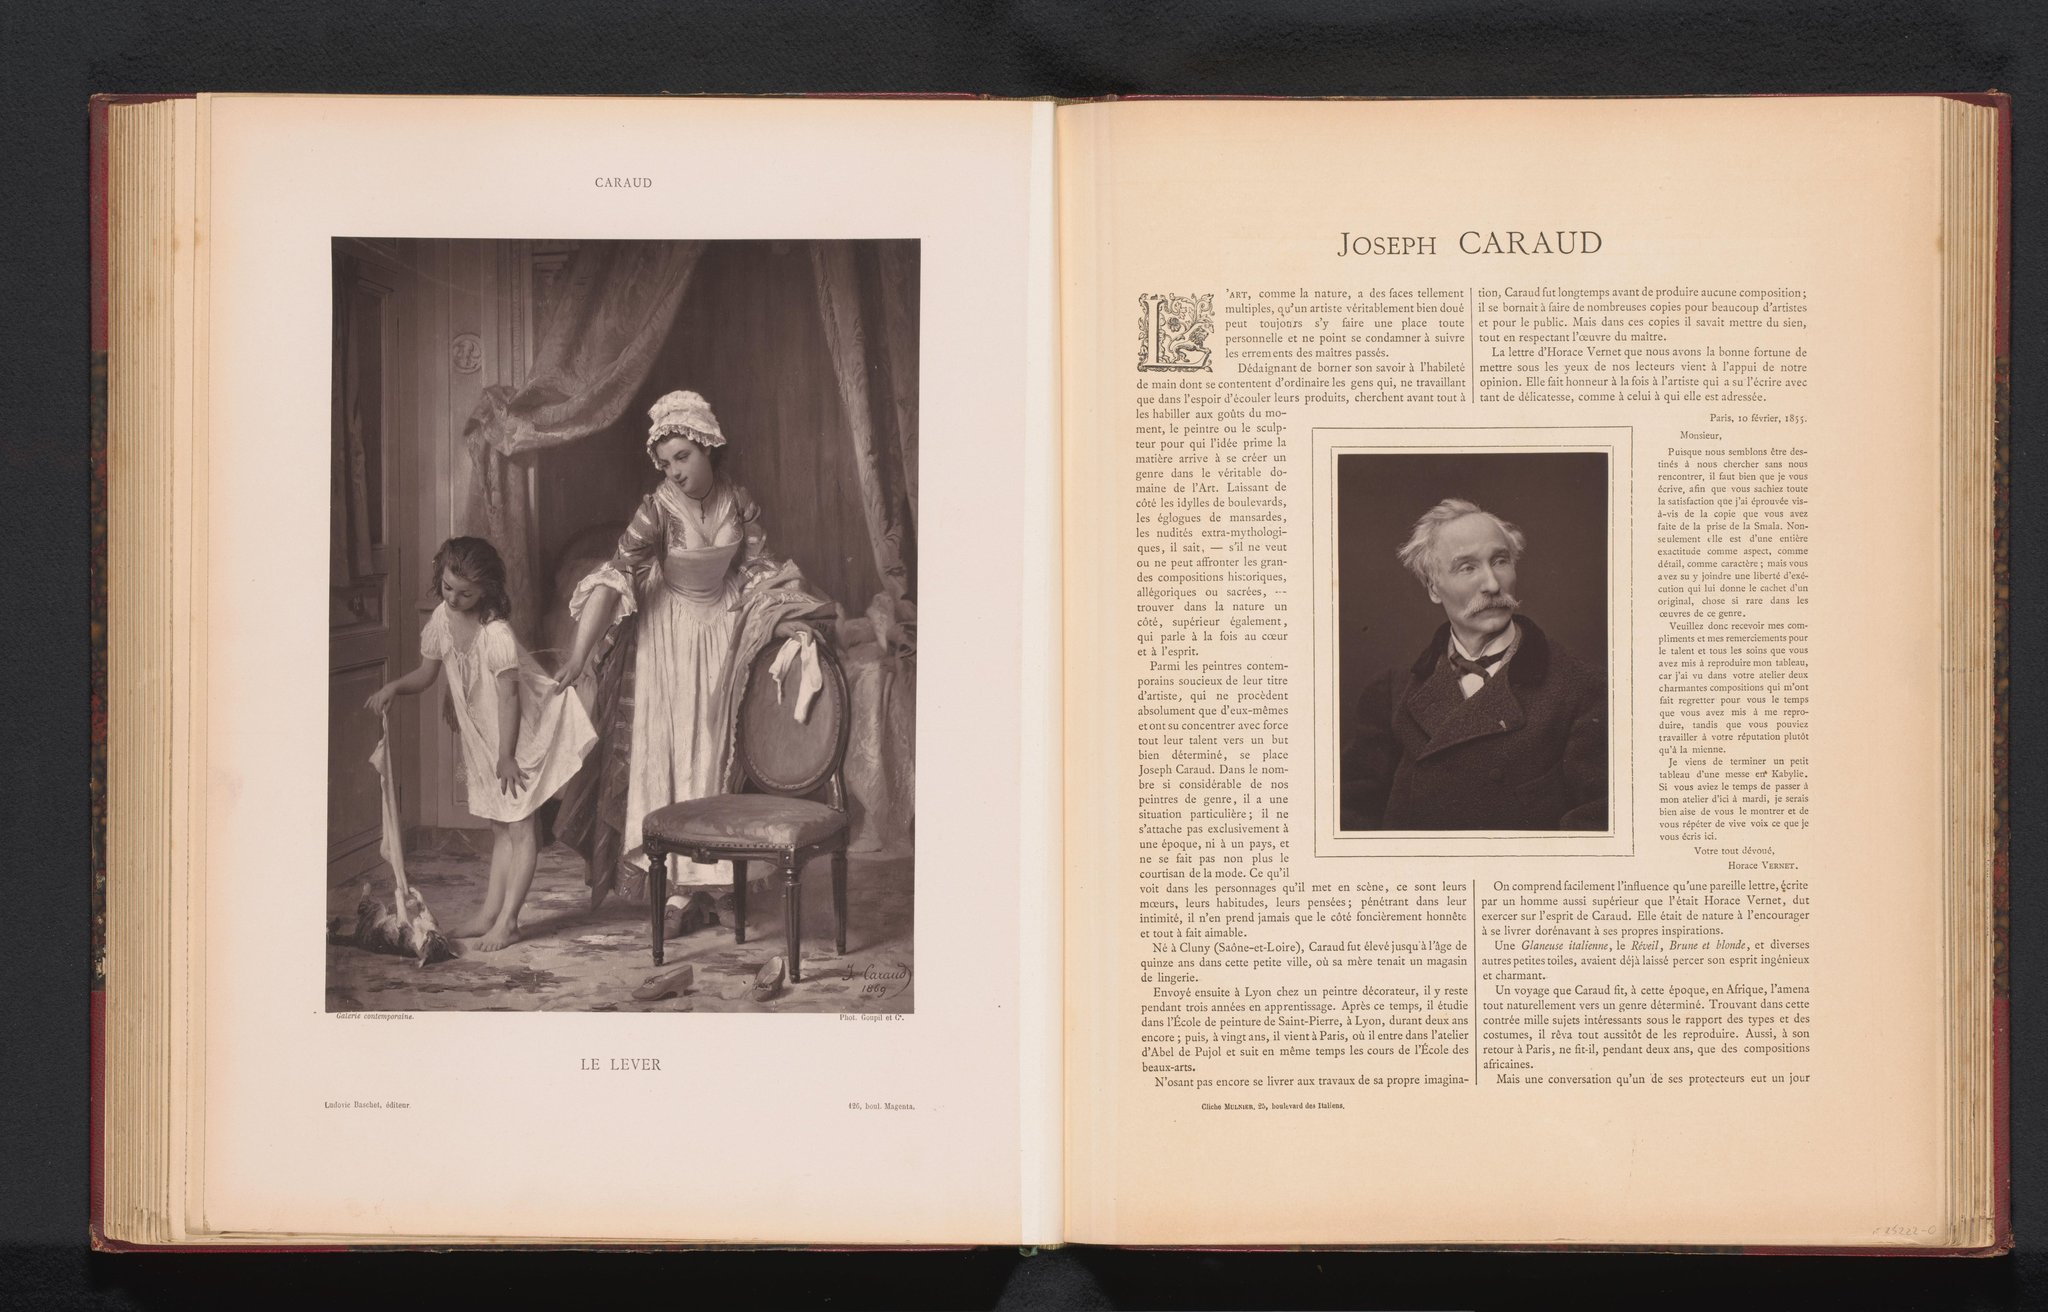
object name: page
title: Le Lever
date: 1874-1879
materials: paper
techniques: woodburytype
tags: child (at home) - aa - girl, maid ~ house personnel, painting, drawing and the graphic arts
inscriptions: inscription: ‘Galerie Contemporaine/ Ludovic Baschet, éditeur./ 126, boul. Magenta.’